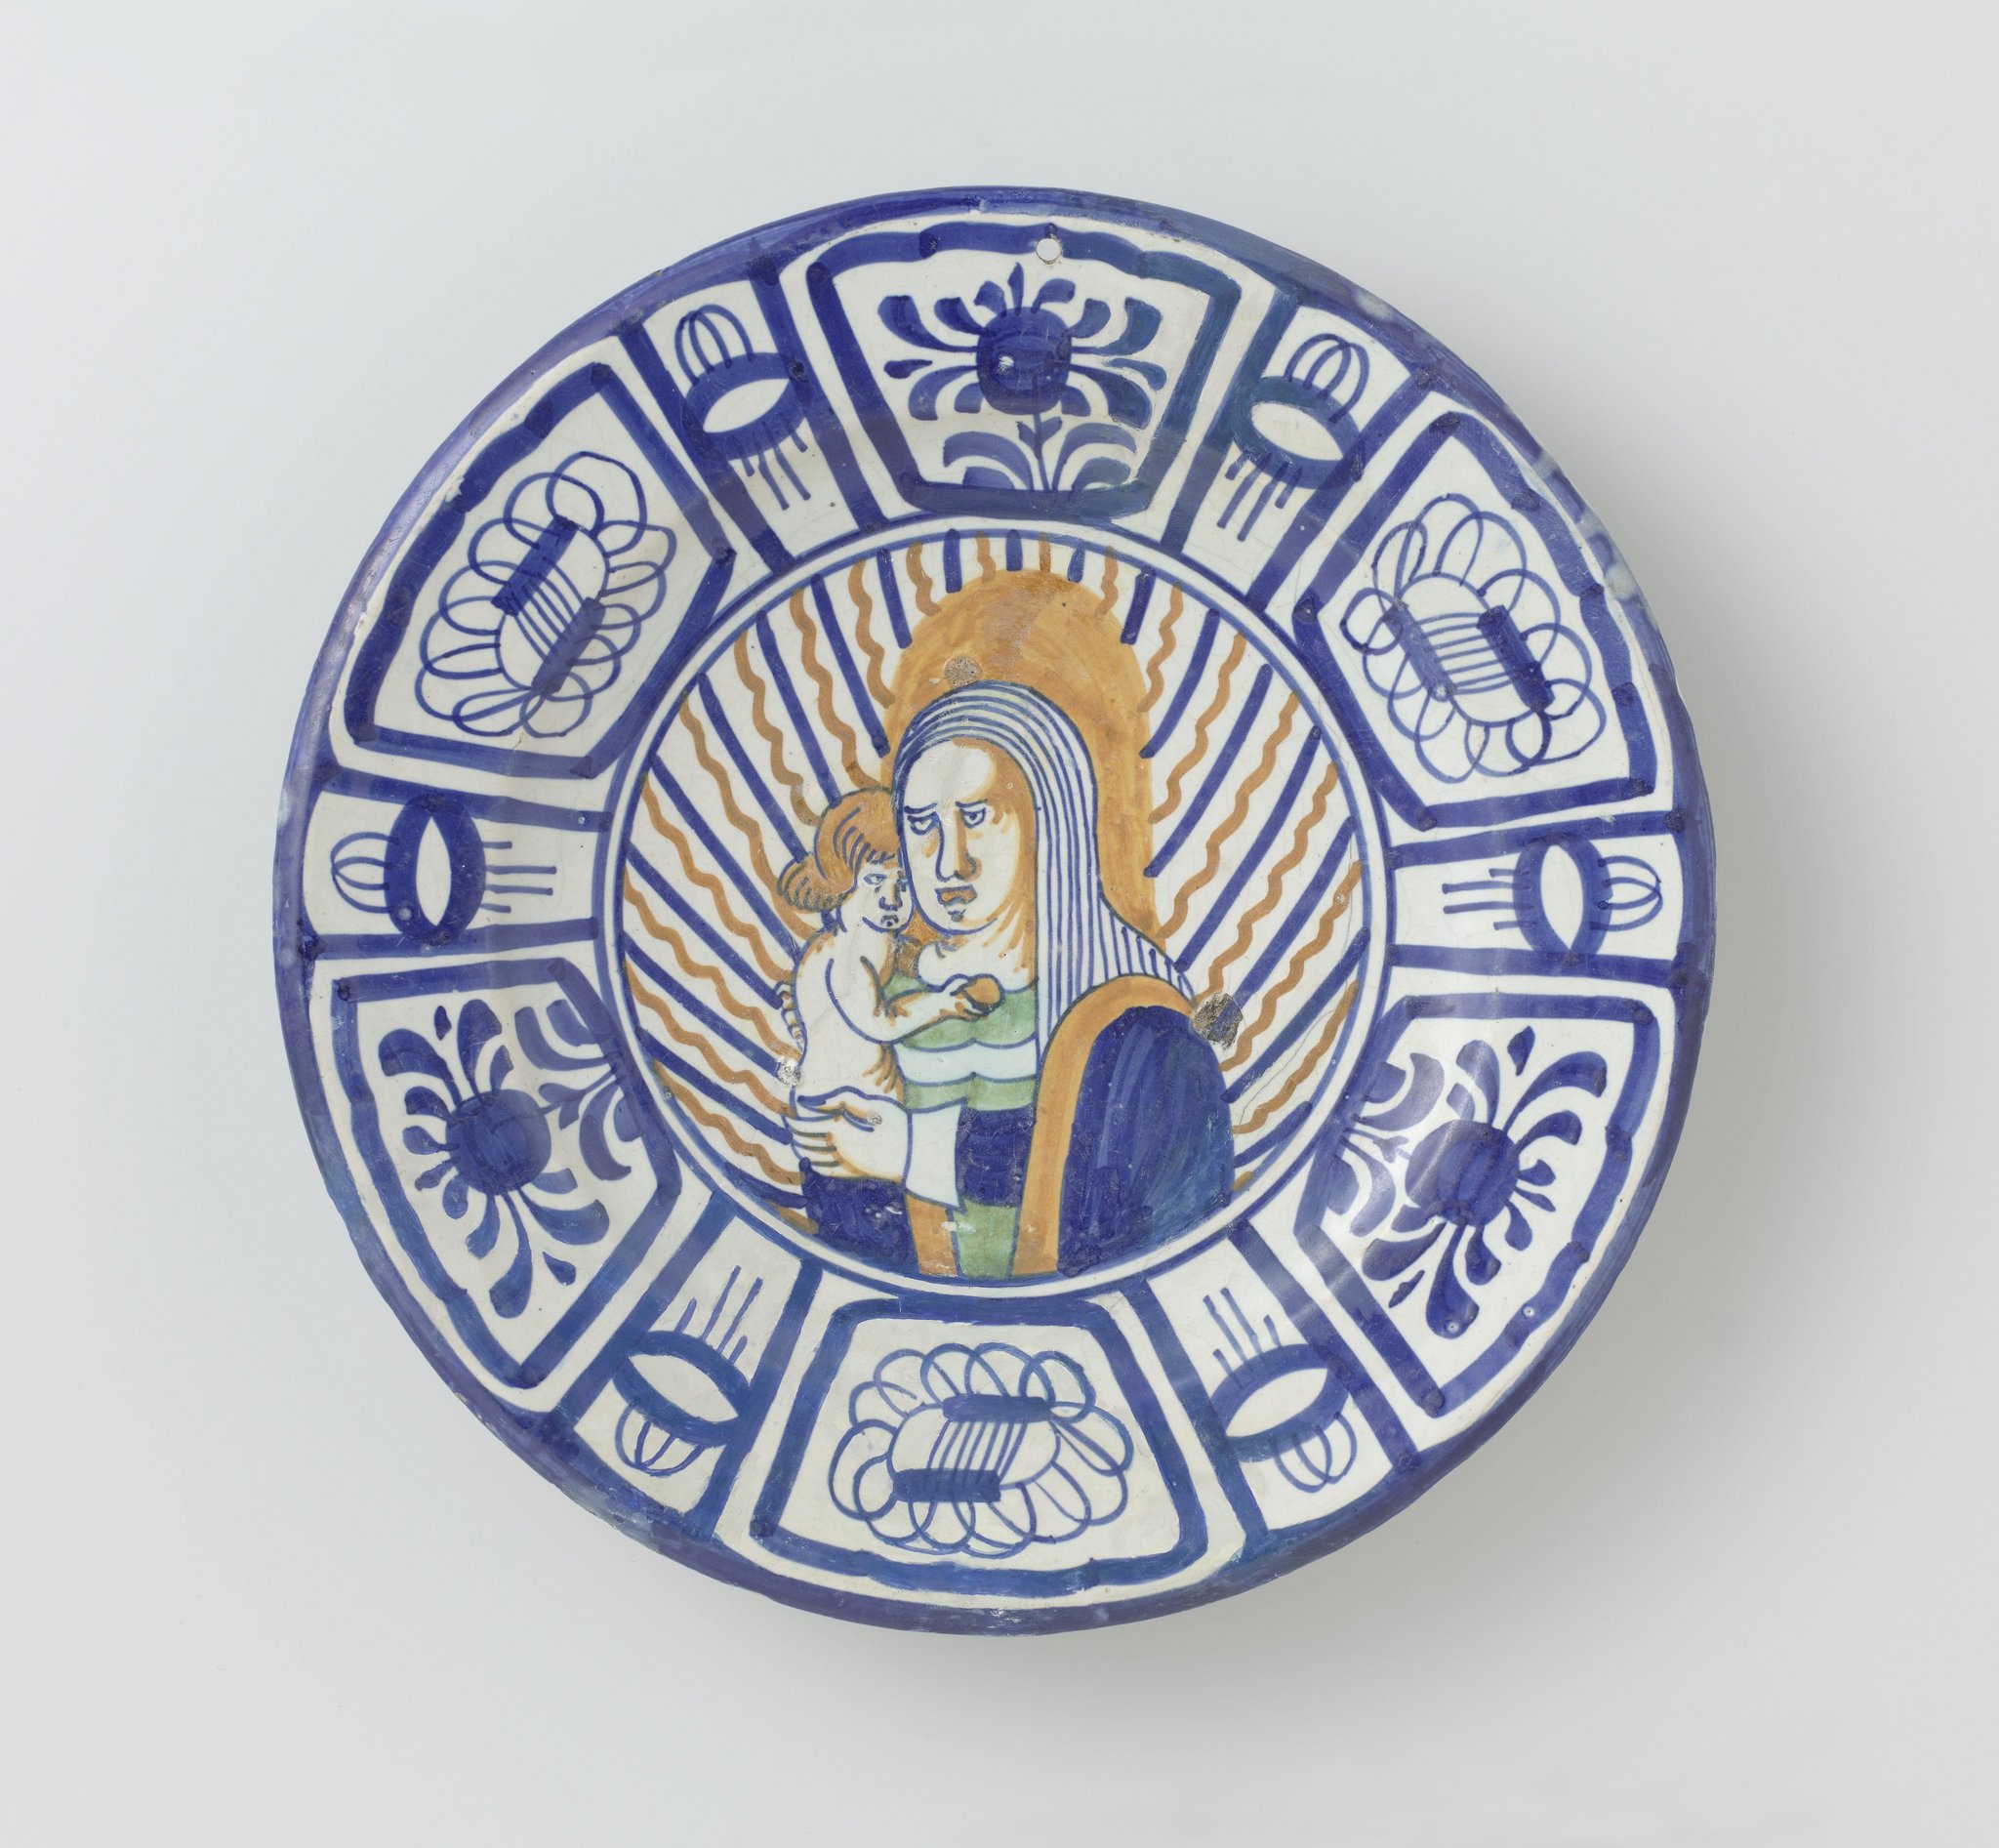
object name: platter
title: Schotel, veelkleurig beschilderd met op het plat een Madonna met Kind, omgeven door een stralenkrans.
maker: Anonymous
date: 1625-1645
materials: earthenware, glaze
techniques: maiolica, painted, polychromy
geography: netherlands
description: Dish c. 1630 - 1650. Dish with Madonna and Child, c. 1630 - 1650.